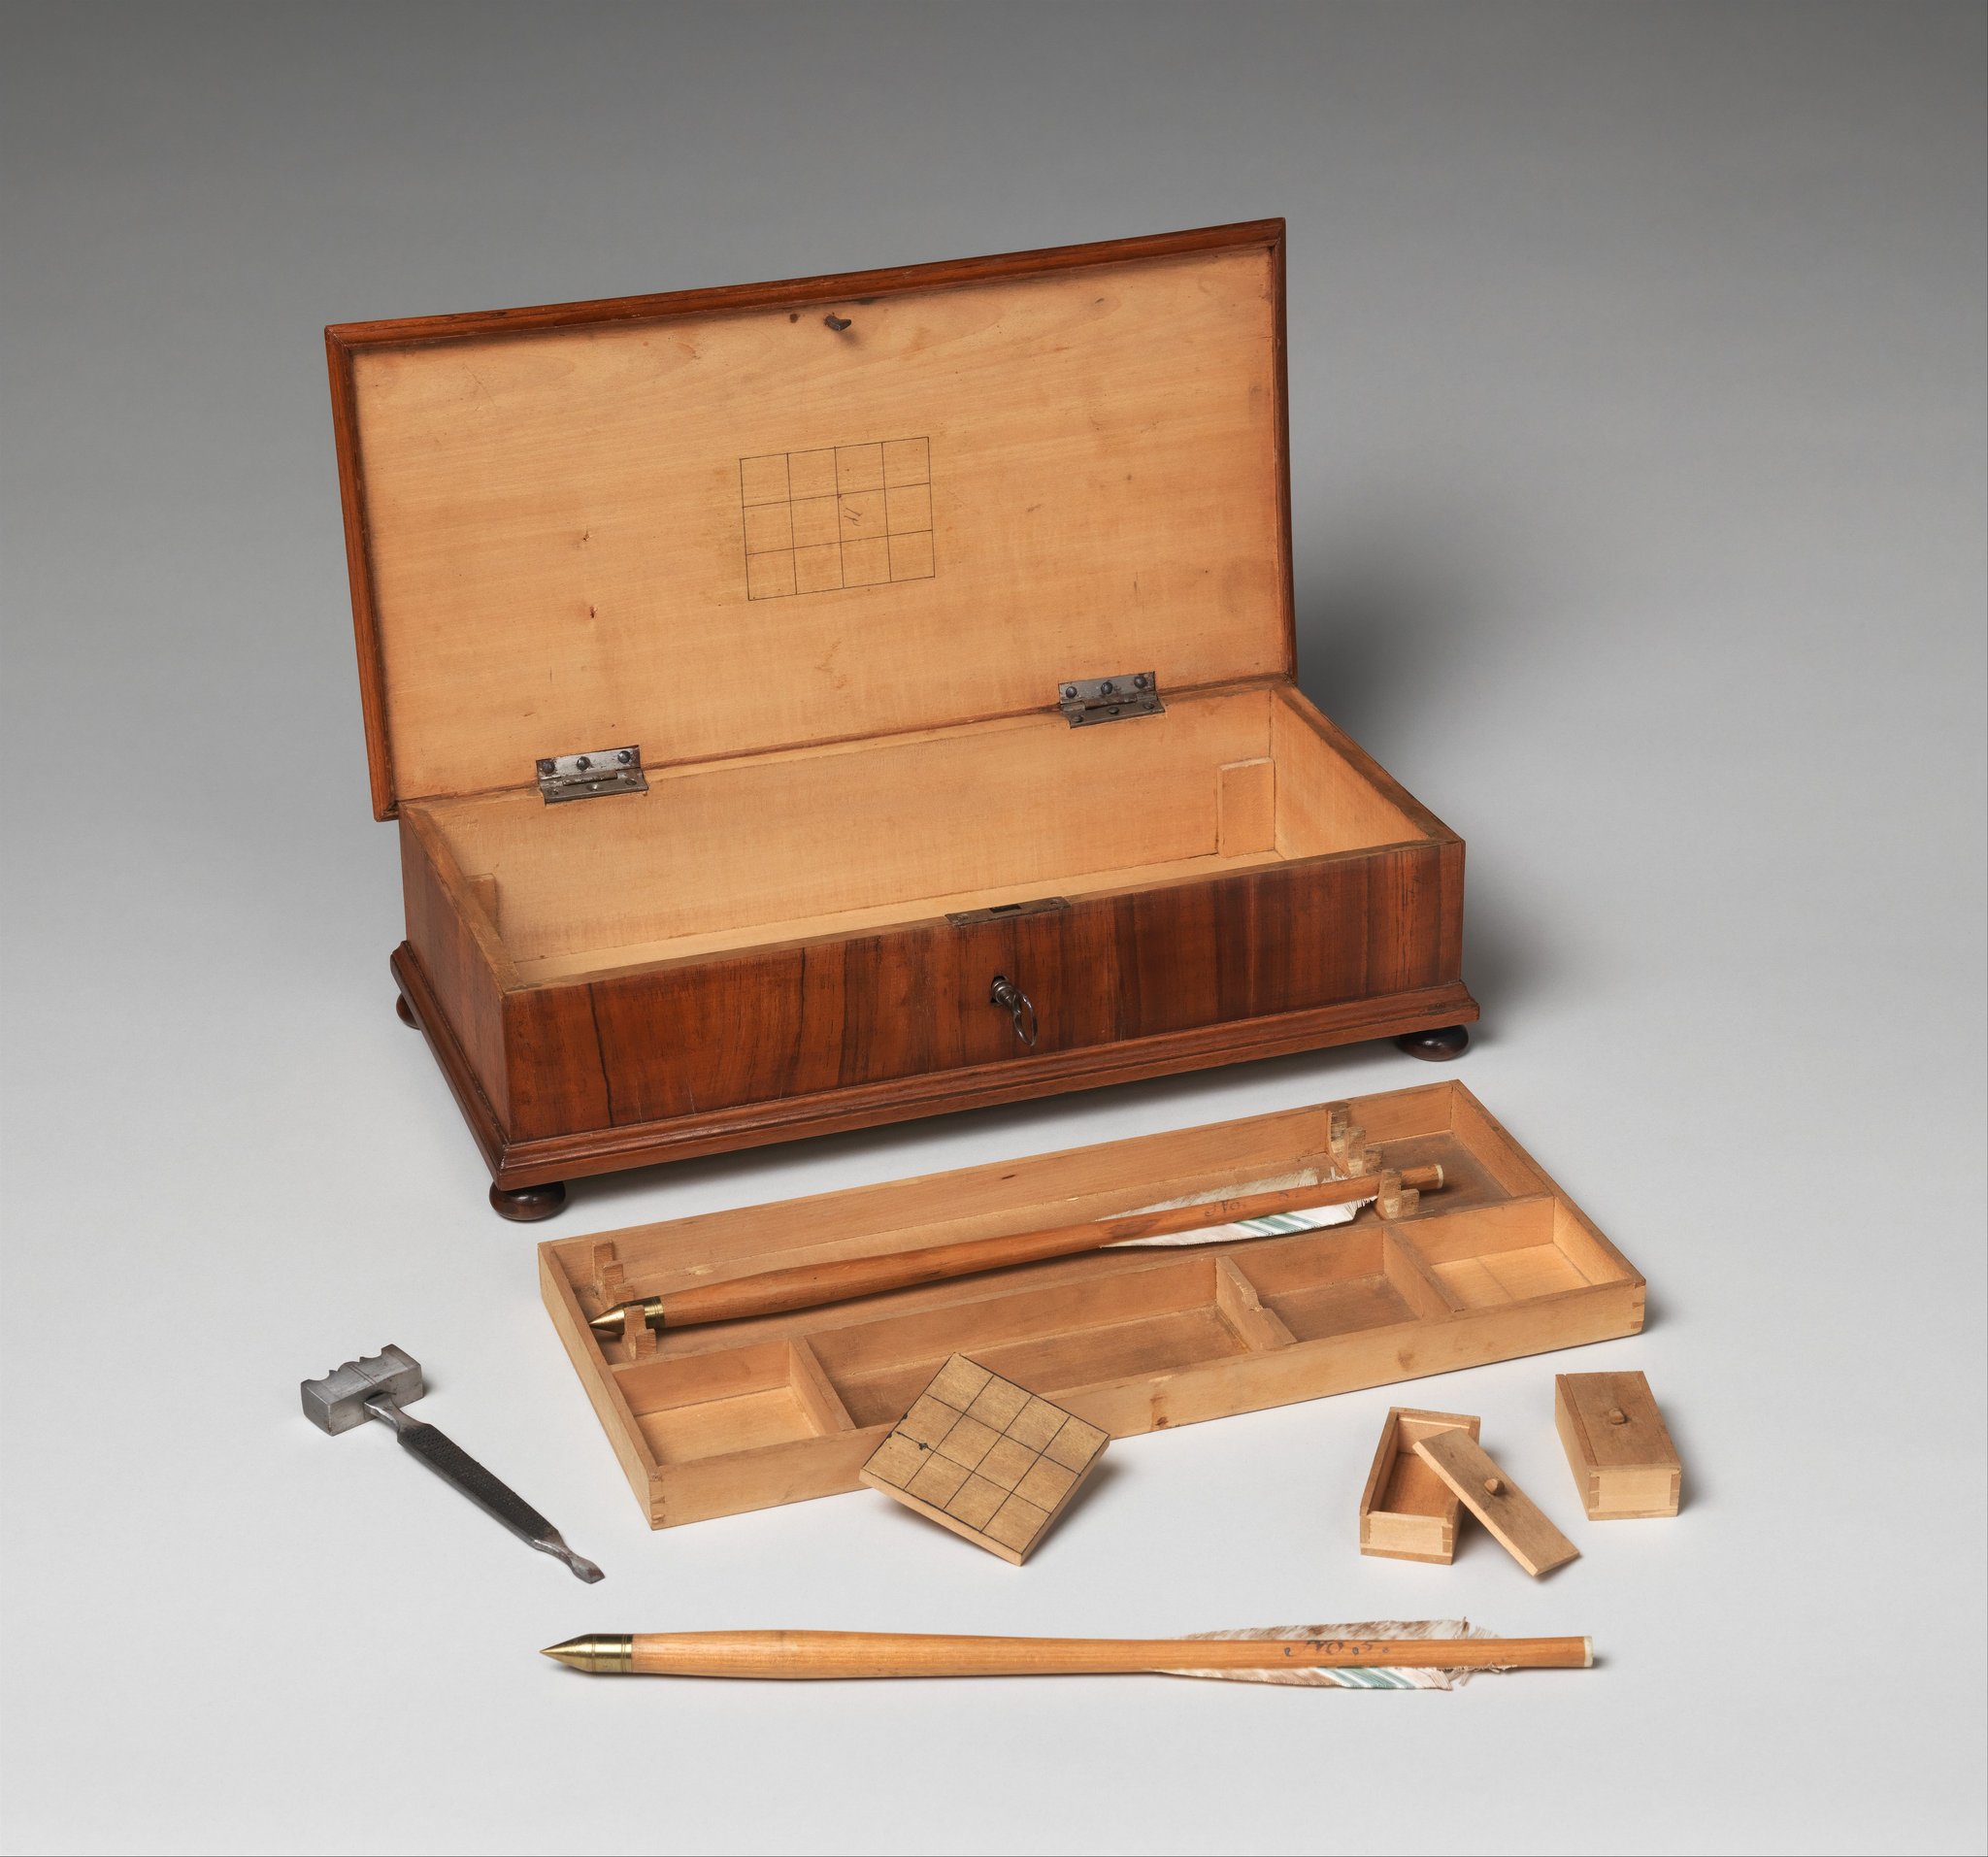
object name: crossbow bolt box bolzenkasten with accessory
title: Crossbow Bolt Box (Bolzenkasten) with Accessories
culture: german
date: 1735-1750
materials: copper alloy, feather, metal alloy, steel, wood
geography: germany